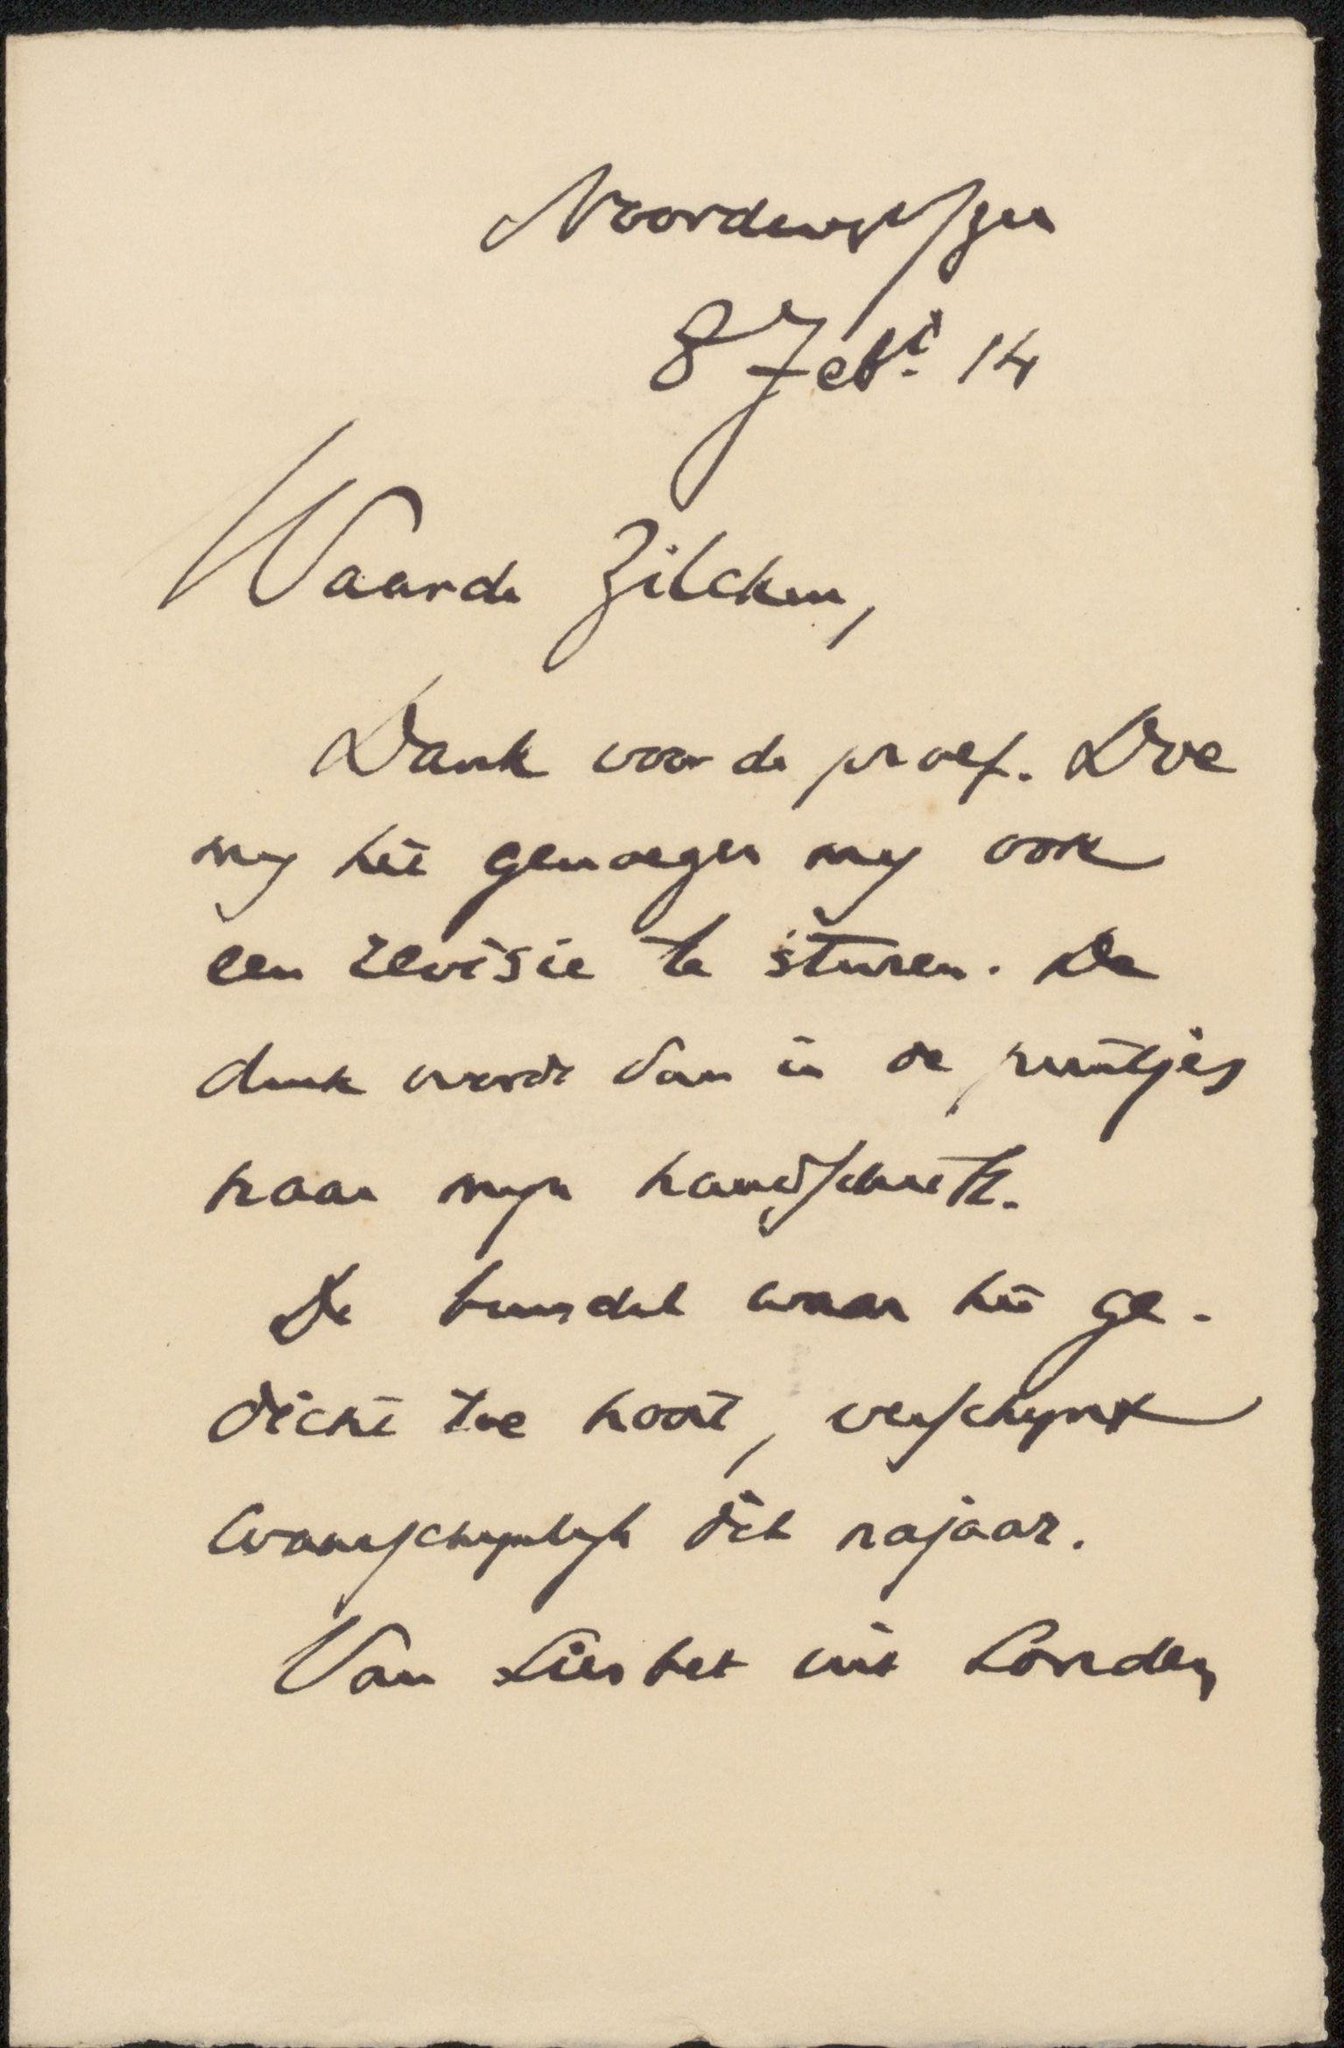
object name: letter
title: Brief aan Philip Zilcken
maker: albert verwey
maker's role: criticus, dichter, essayist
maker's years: 1865-1937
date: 1914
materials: ink, paper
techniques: pen, writing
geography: noordwijk aan zee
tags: the hague, painter, philip zilcken, literature ~ arts, money, london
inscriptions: collector's mark: ‘RPK’, watermark